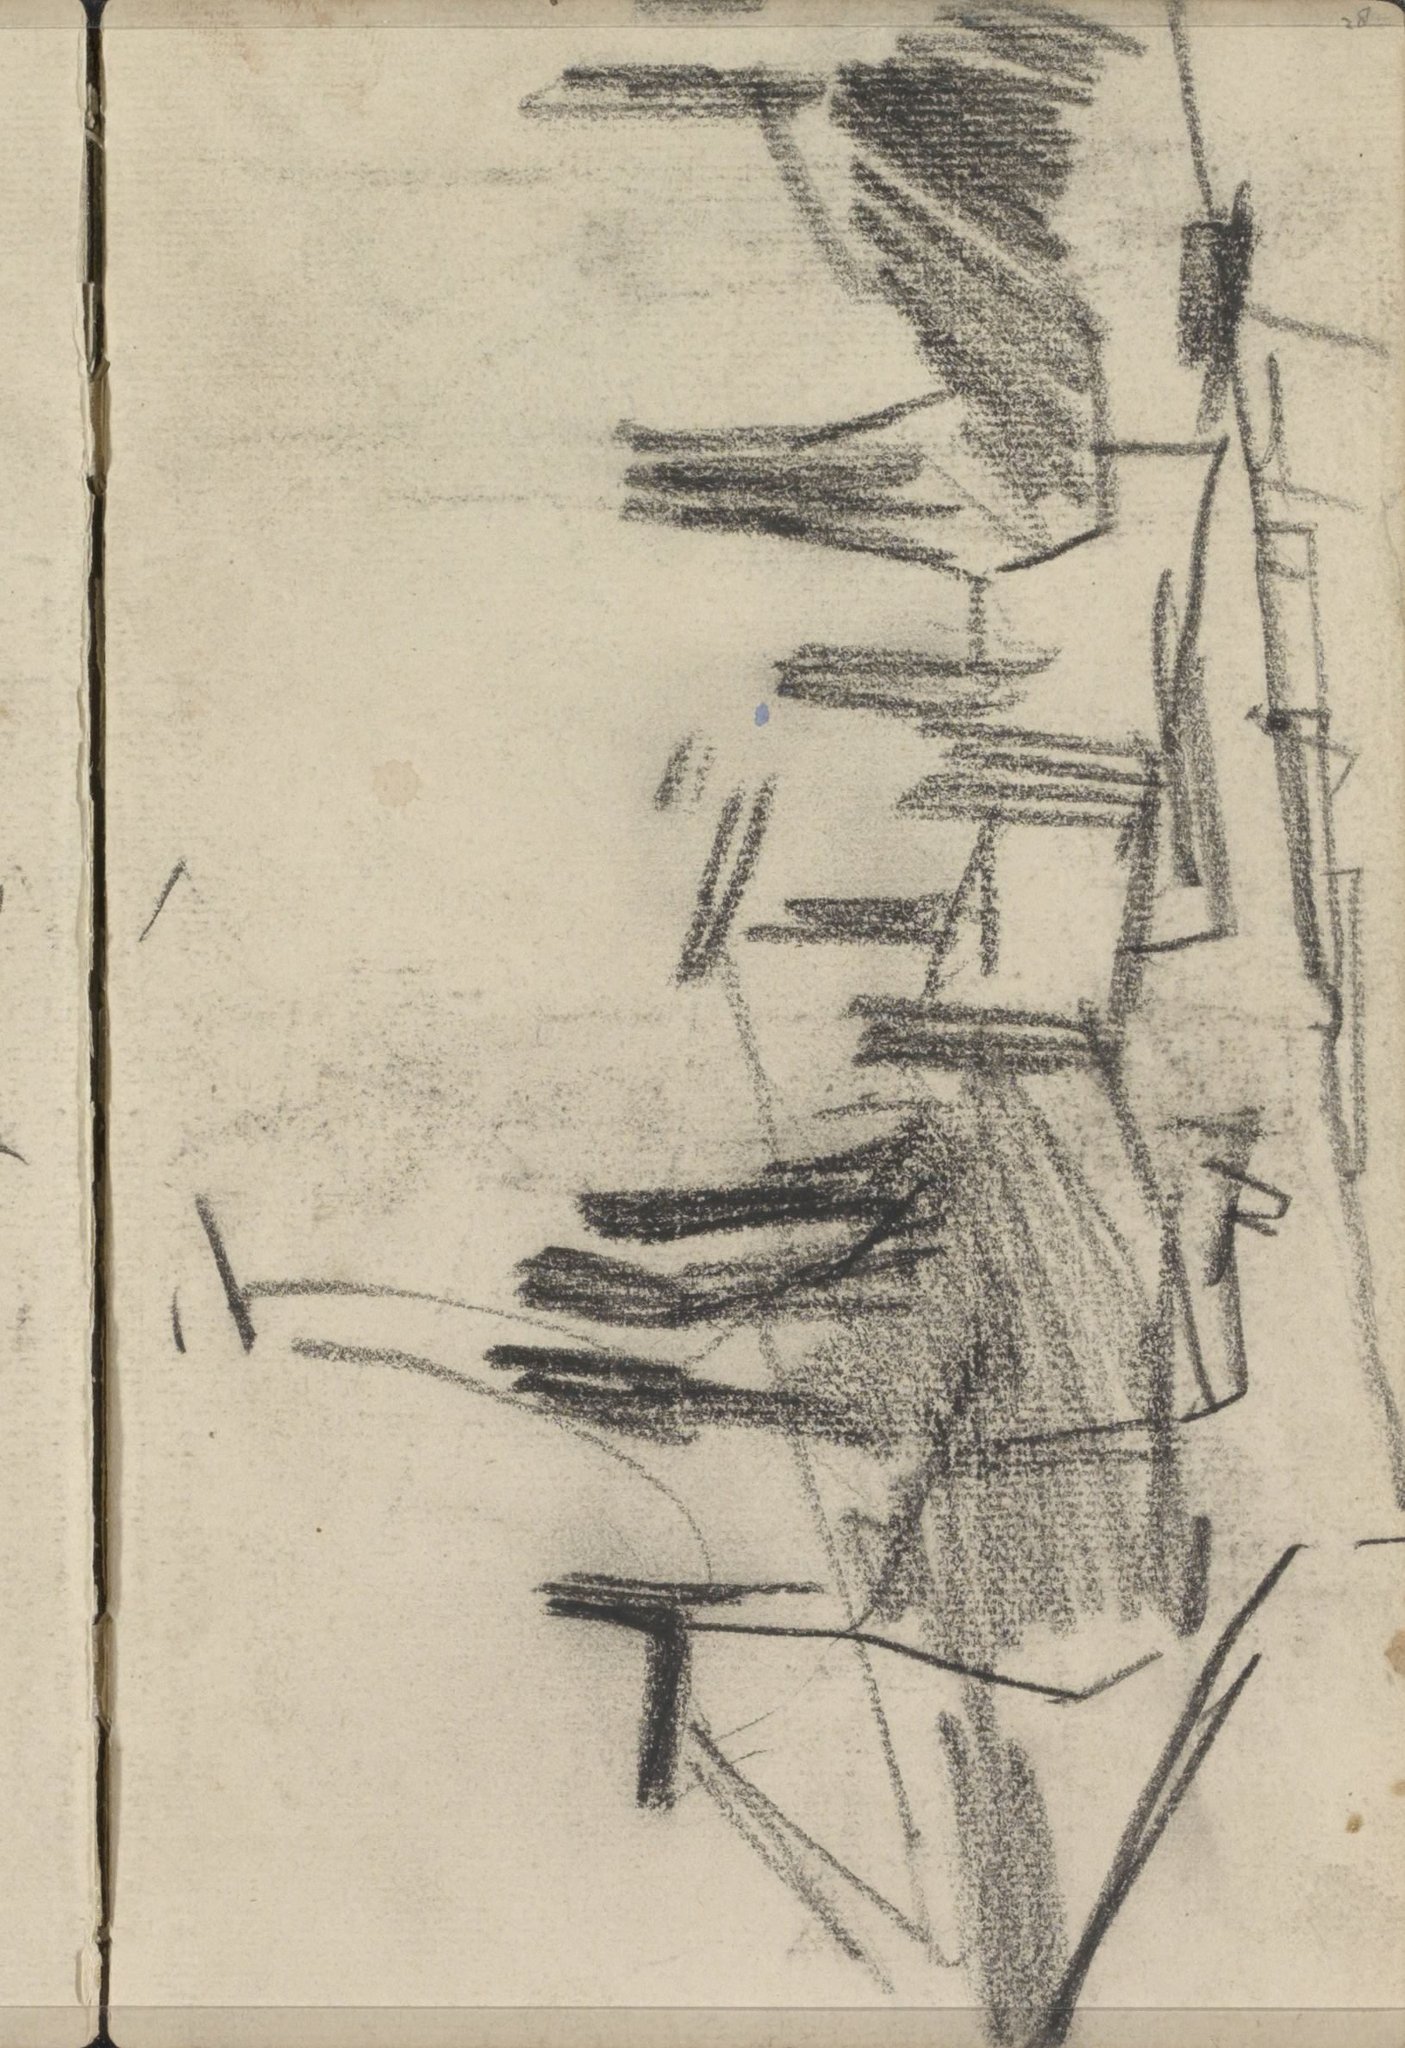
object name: sketchbook leaf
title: Dieren, mogelijk paarden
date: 1881-1883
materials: chalk, paper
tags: horse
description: Pagina 28 uit een schetsboek met 19 bladen.